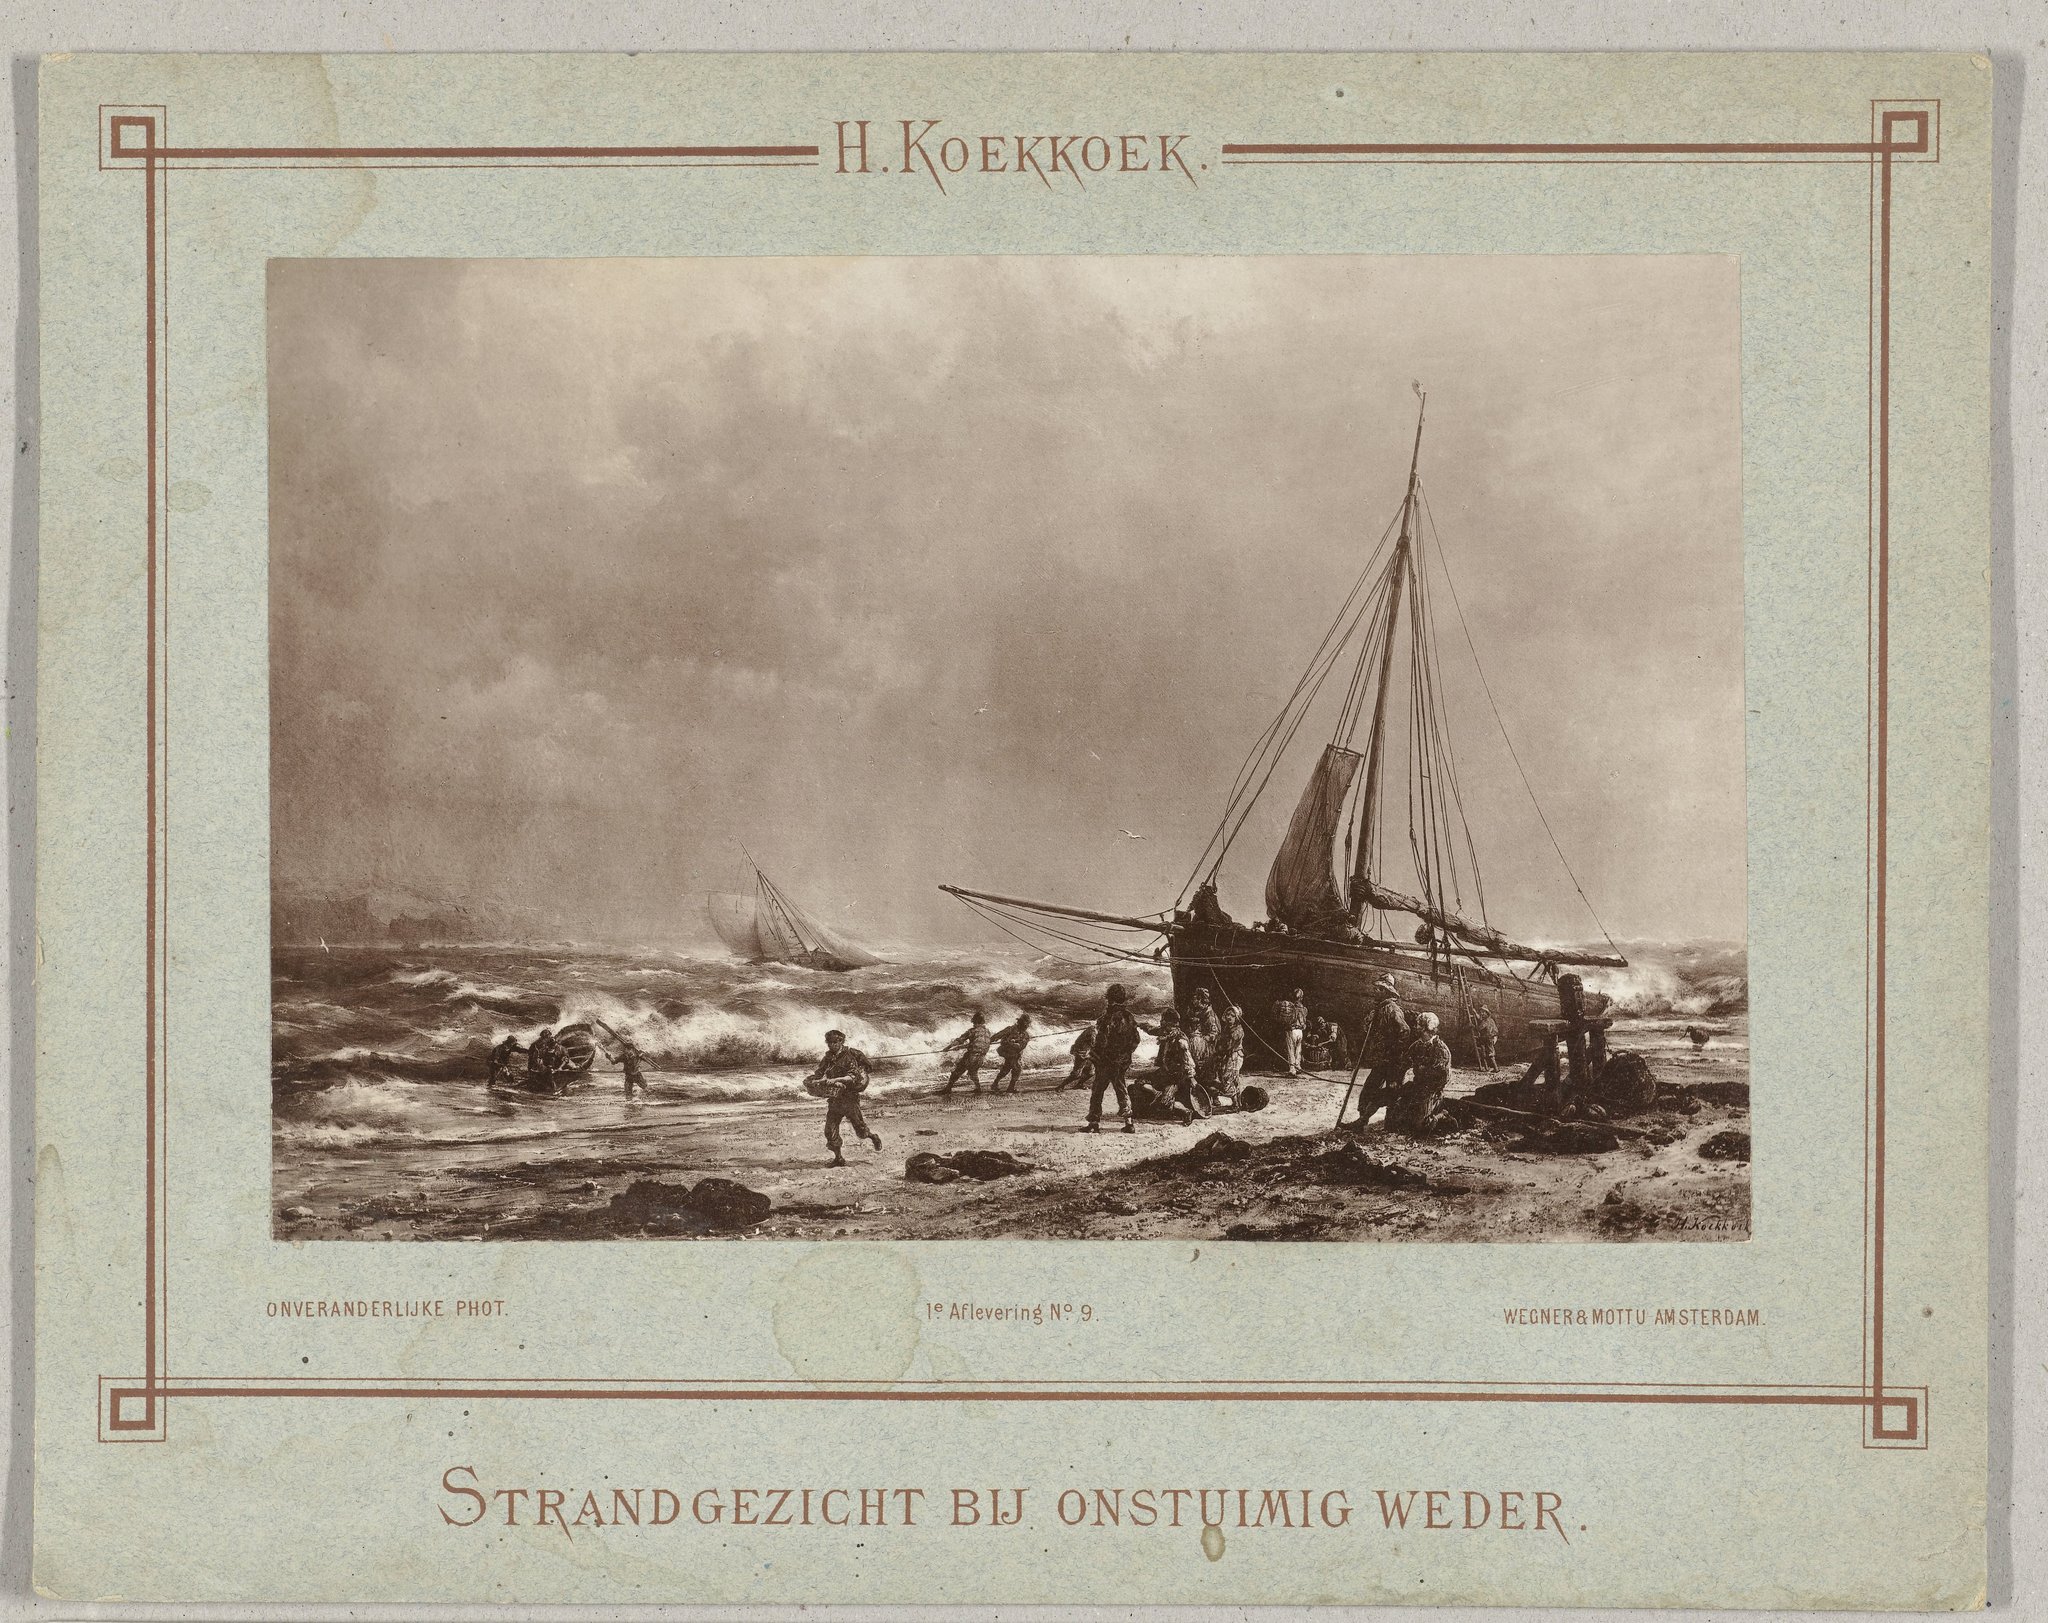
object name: photograph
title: H. Koekkoek. Strandgezicht bij onstuimig weer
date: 1880-1900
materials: cardboard, paper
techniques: photograph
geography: amsterdam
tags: sea (seascape)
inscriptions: inscription: ‘H. KOEKKOEK. / STRANDGEZICHT BIJ ONSTUIMIG WEDER. / ONVERANDERLIJKE PHOT. / 1e Aflevering No. 9. / WEGNER & MOTTU AMSTERDAM.’